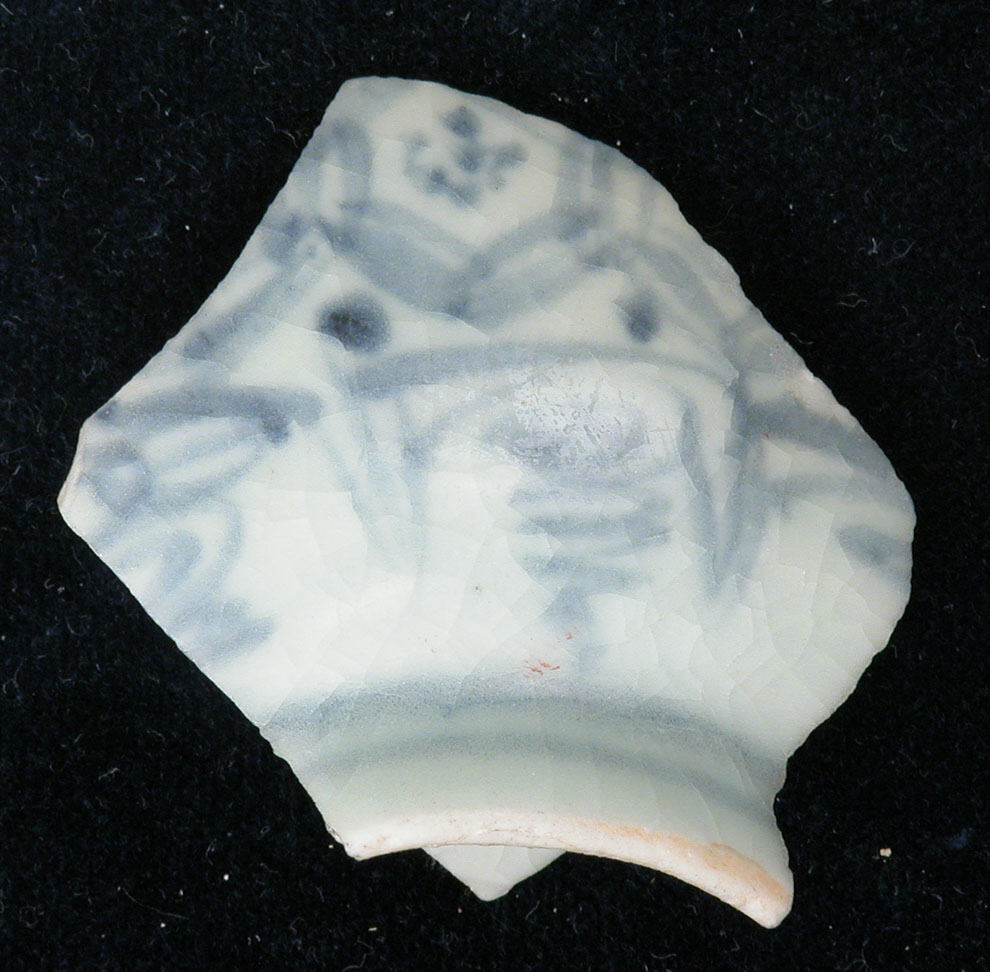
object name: fragment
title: Ceramic Fragment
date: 1201-1400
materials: porcelain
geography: saudi arabia